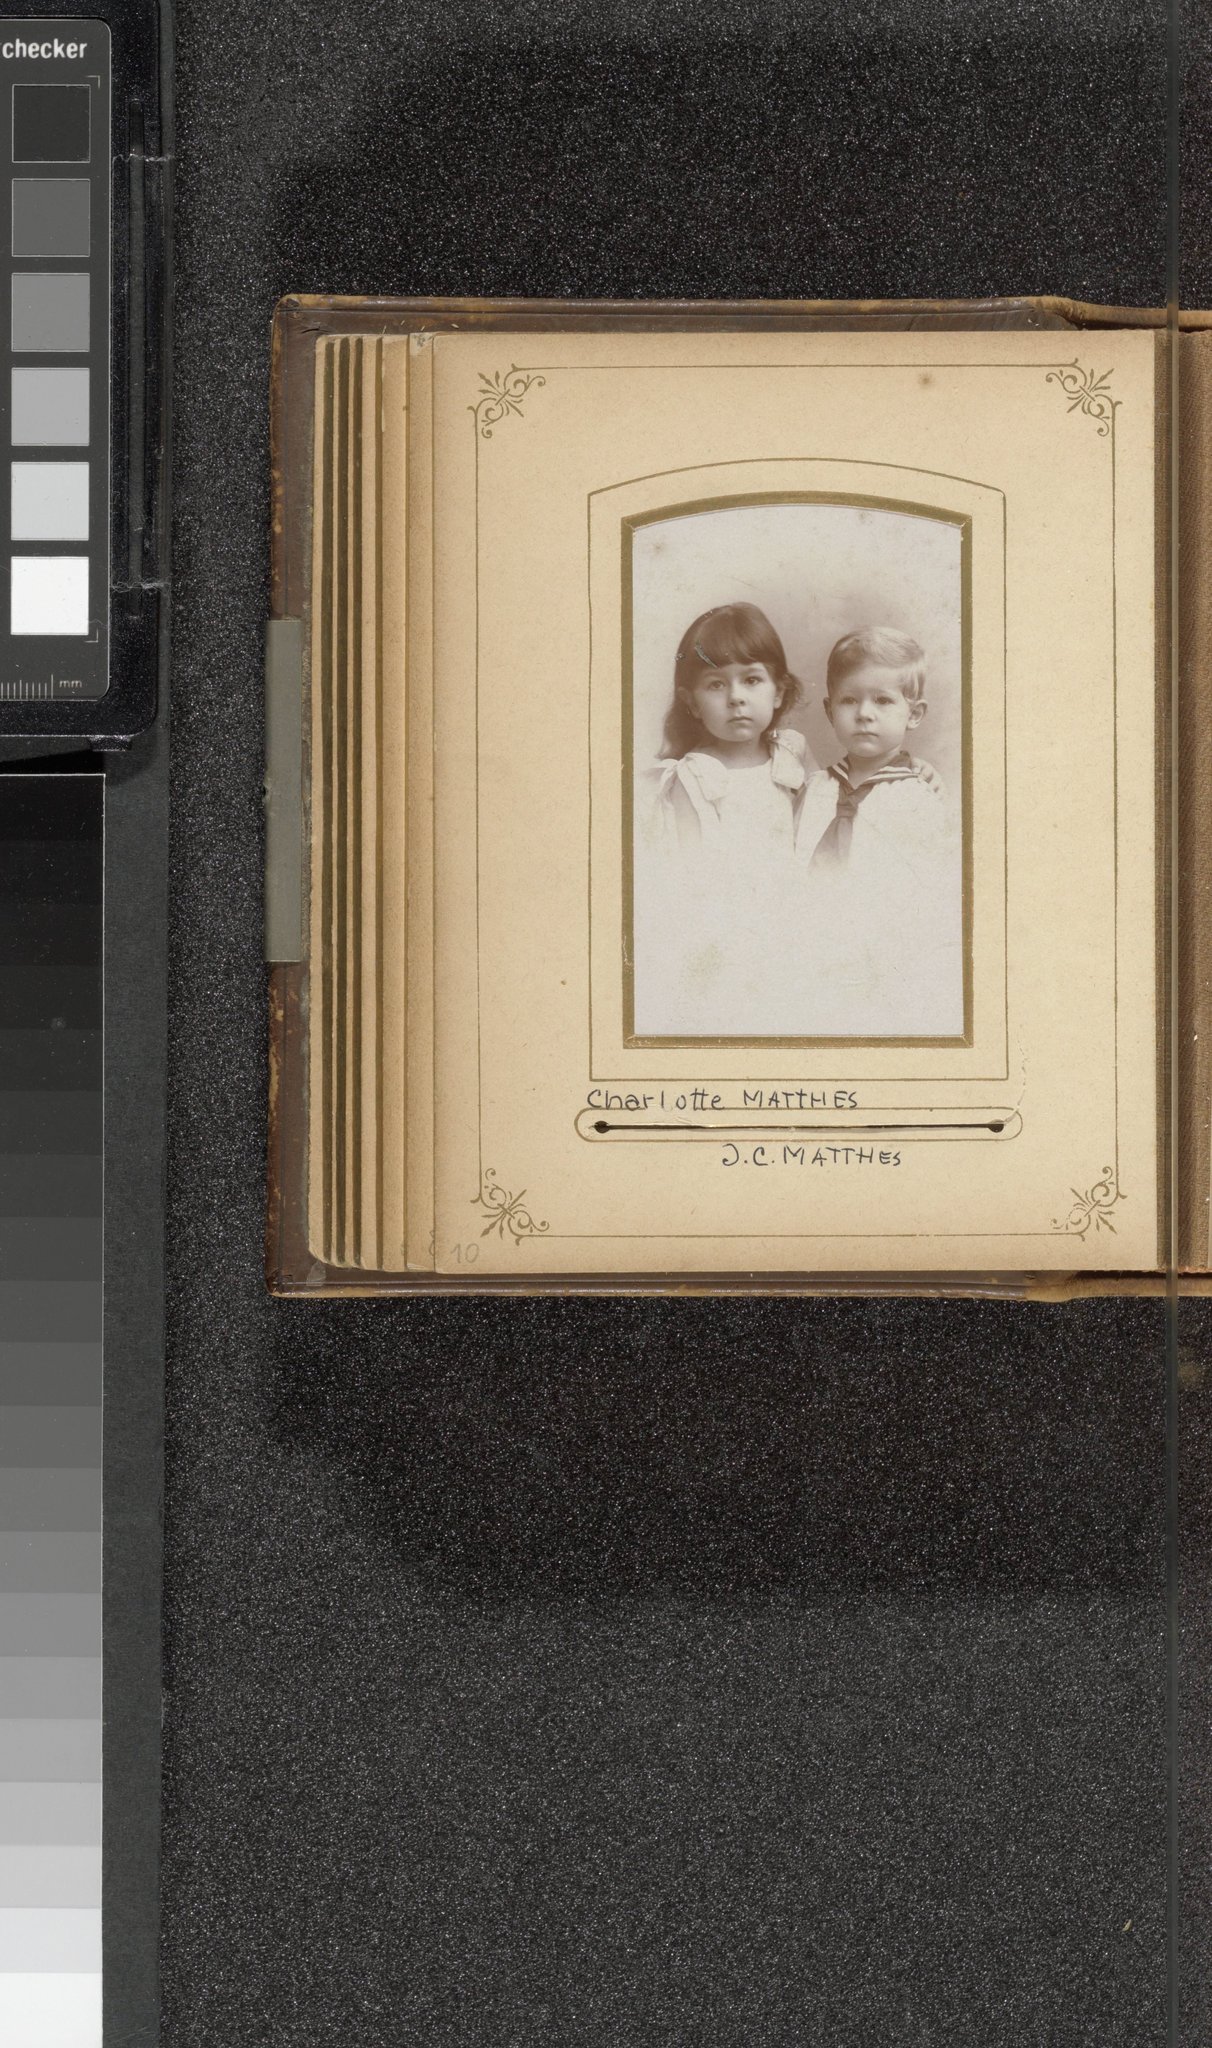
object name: carte de visite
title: Portret van Lot en Carel Matthes als jonge kinderen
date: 1889-1898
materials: cardboard, paper, photographic support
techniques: collodion silver print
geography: medan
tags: charlotte alida boelen-matthes (lot), studio requisites ~ photographer, historical persons - bb - woman, child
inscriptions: name: ‘Lottie 3 1/2 jaar Careltje 2 1/2 jaar’, address: ‘Medan Deli Sumatra's O.K.’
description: Onderdeel van Fotoalbum van de families Boelen, Matthes en Pennink.